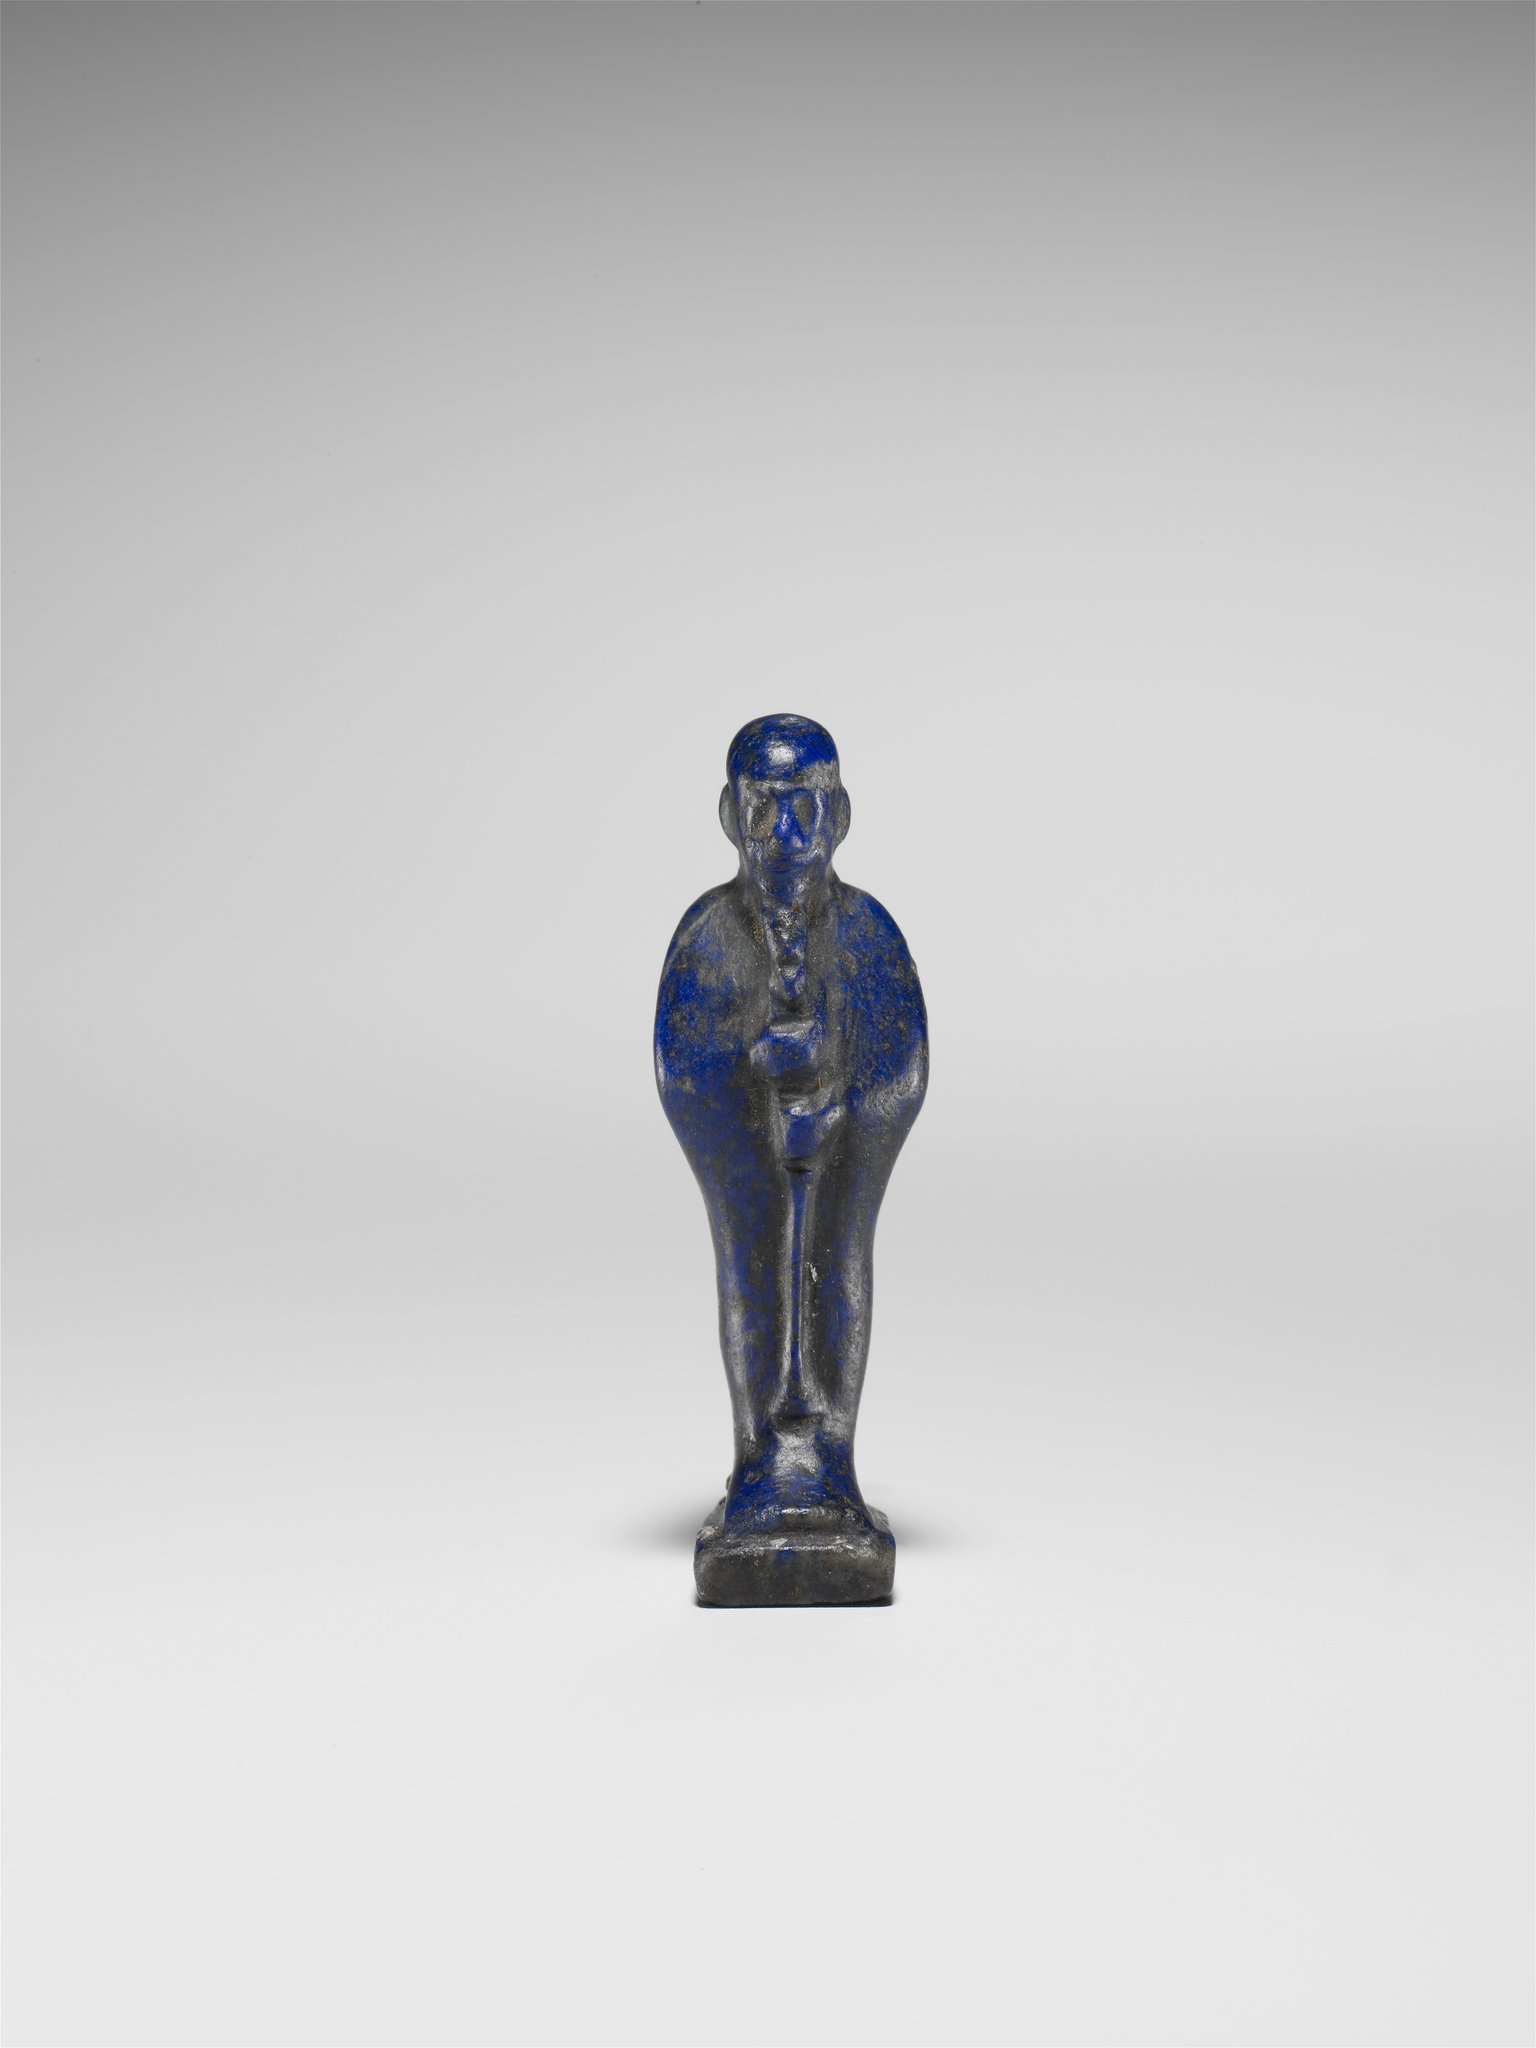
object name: amulet, ptah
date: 664-332 BCE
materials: lapis lazuli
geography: egypt